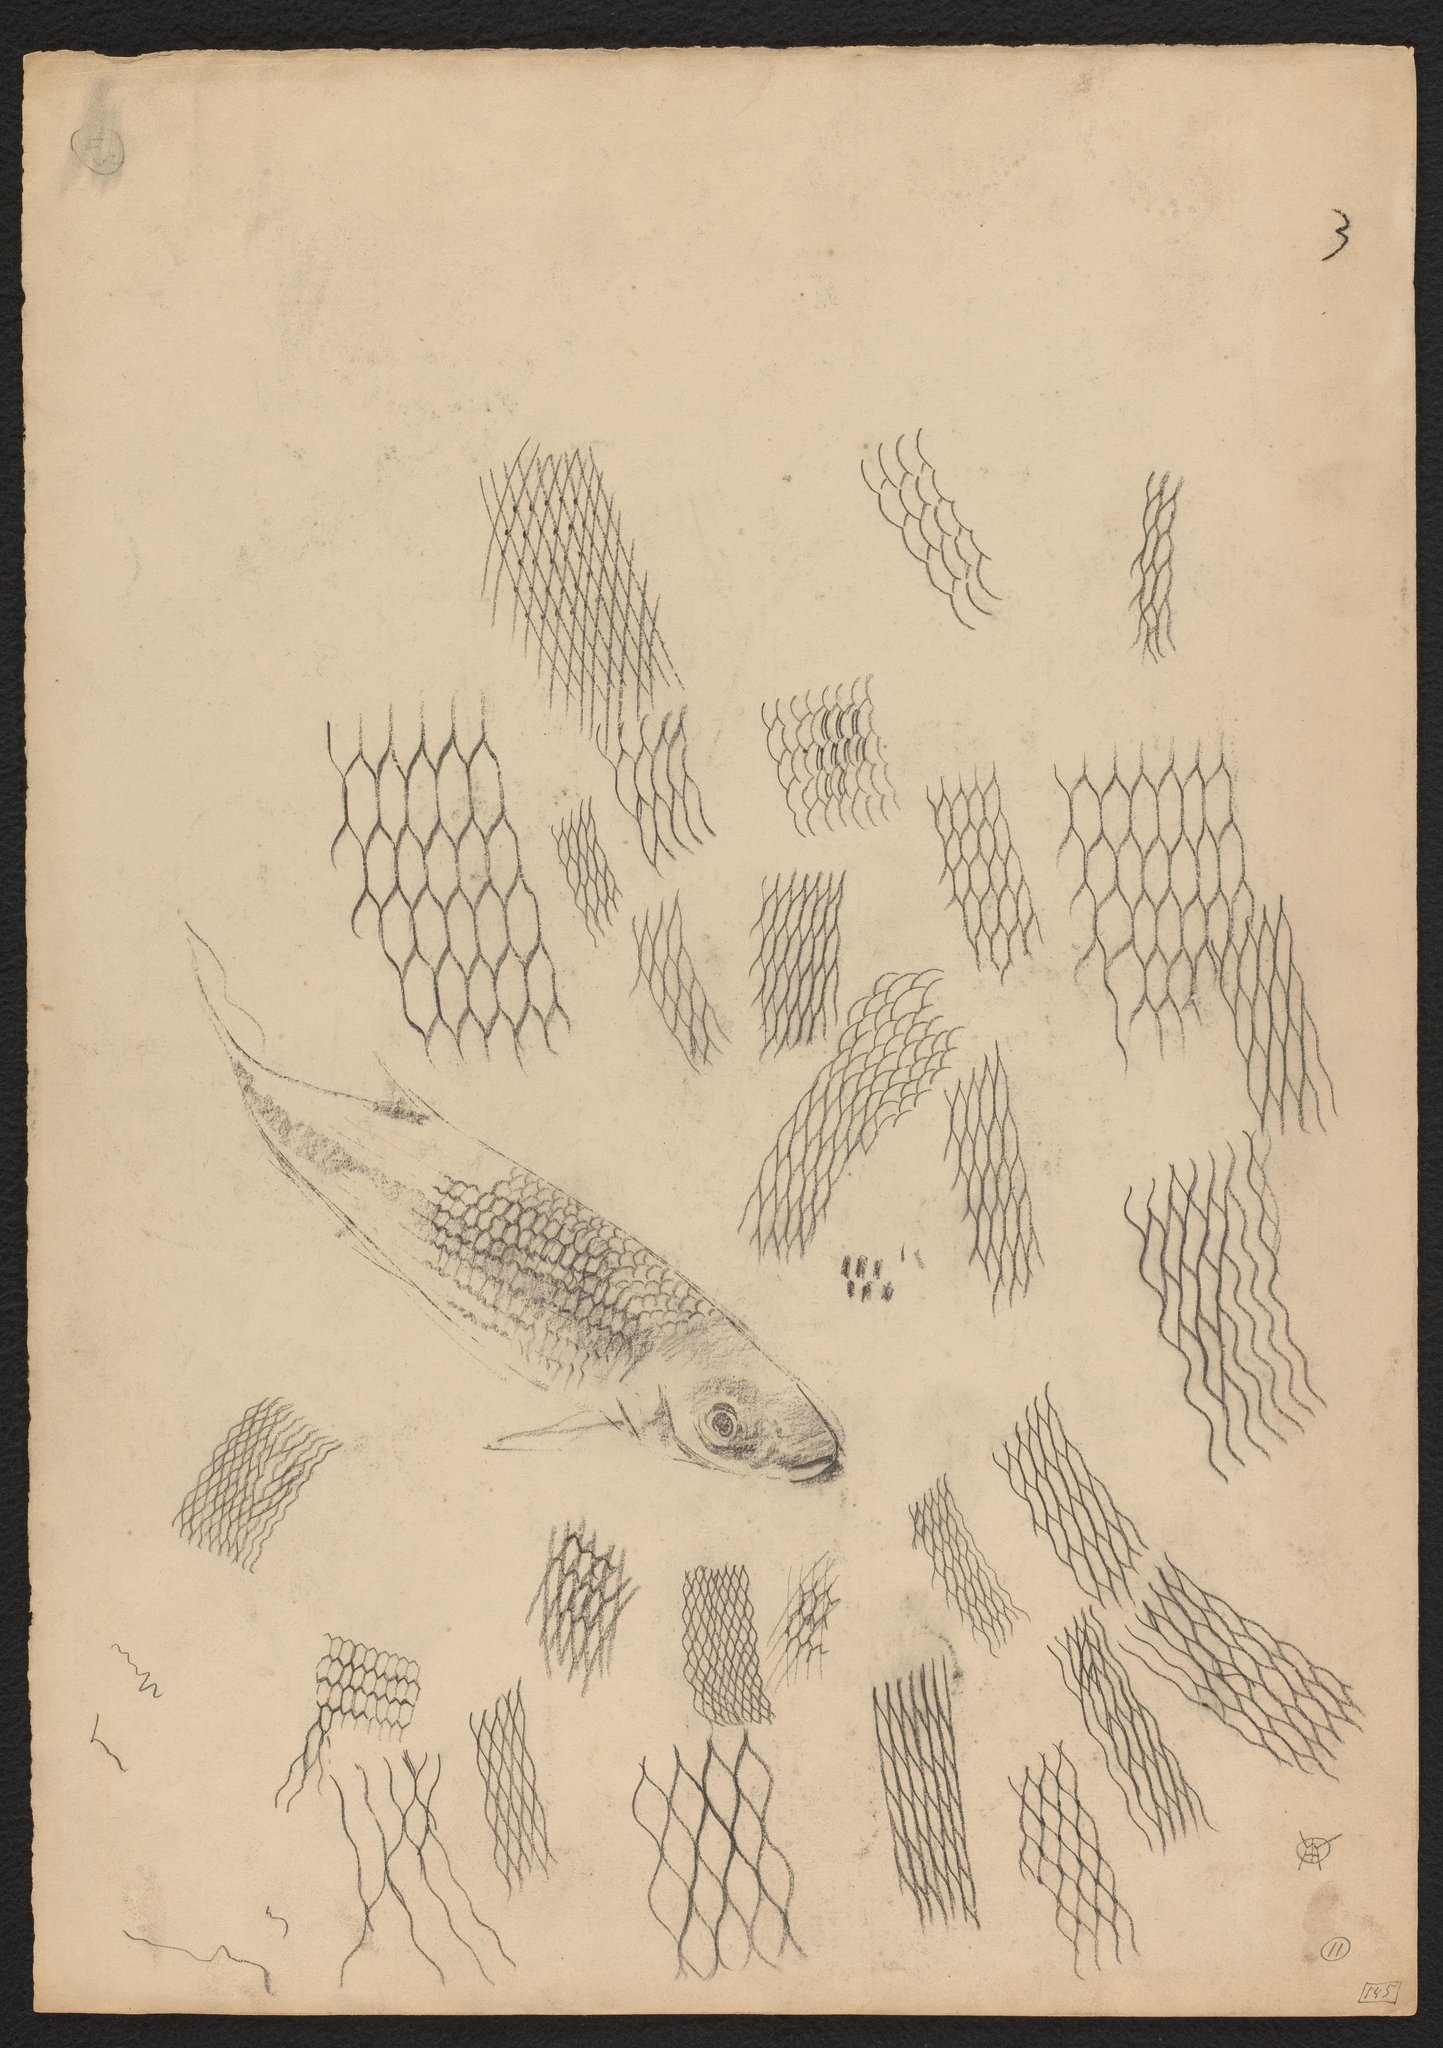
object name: drawing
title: Schetsblad met studies van goudwinden en schubbenstudie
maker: gerrit willem dijsselhof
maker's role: designer, draughtsman, print maker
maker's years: 1866-1924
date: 1876-1924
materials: chalk, paper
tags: fishes